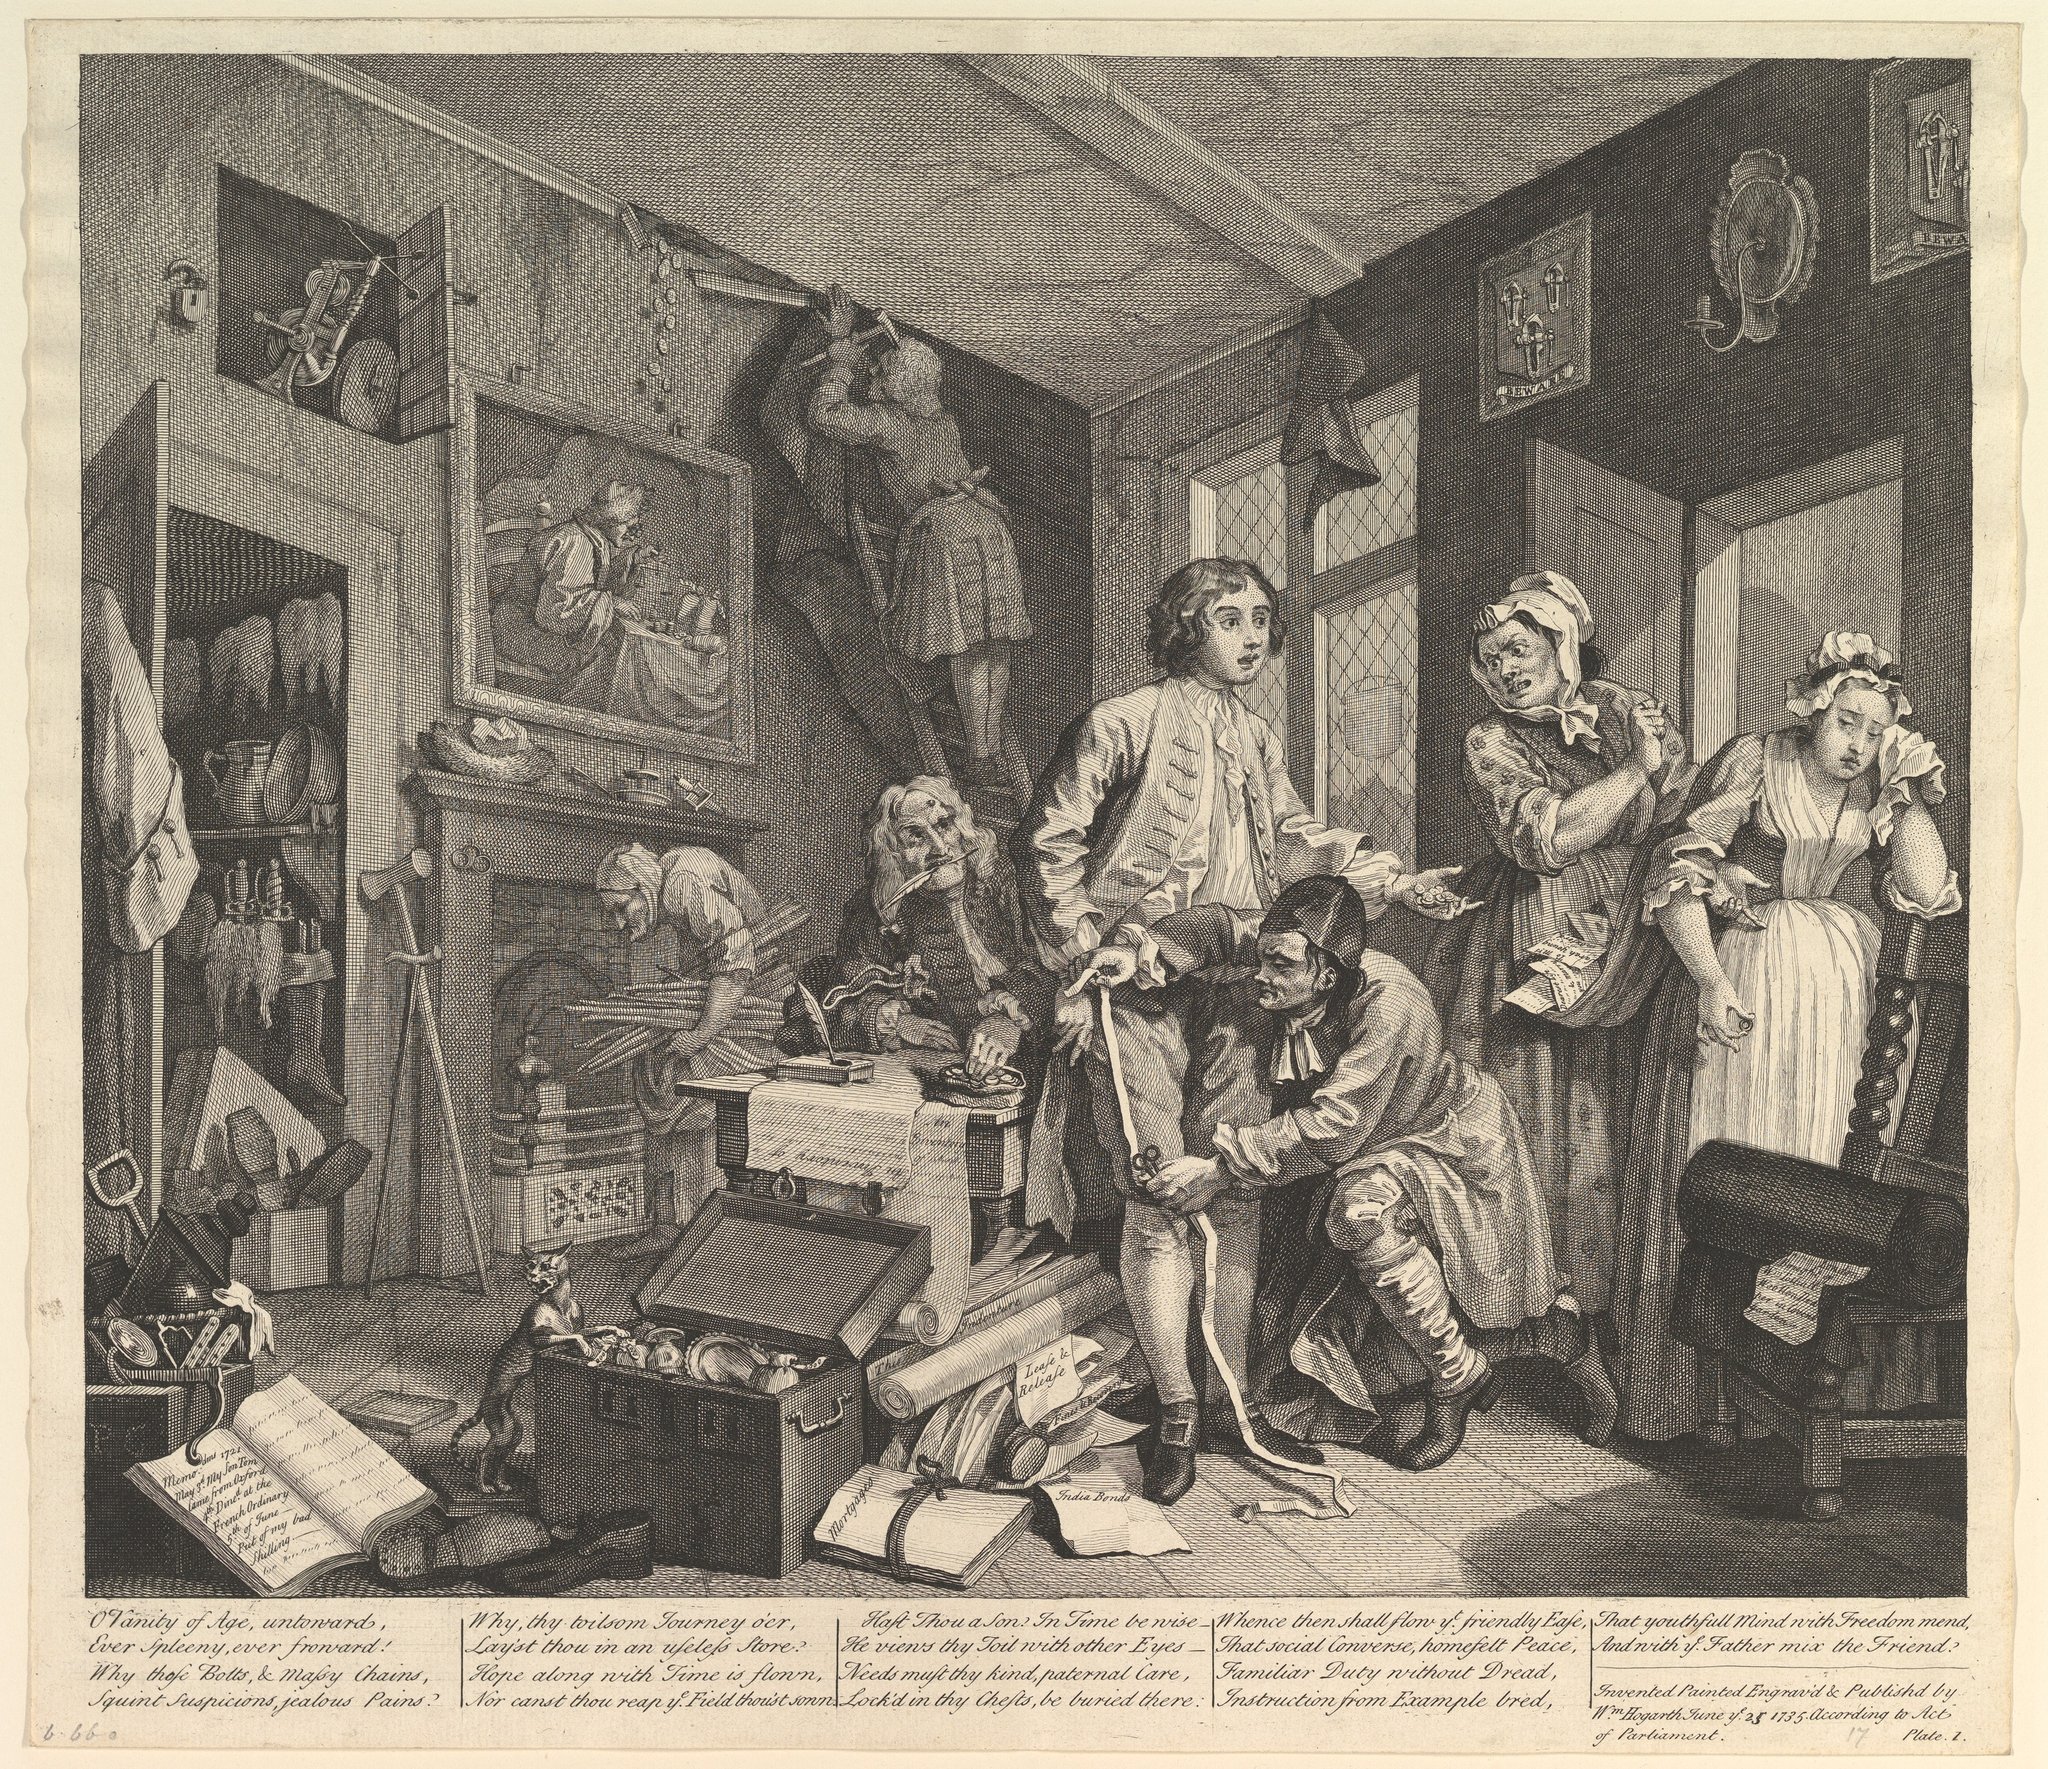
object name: print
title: A Rake's Progress, Plate 1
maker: william hogarth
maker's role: artist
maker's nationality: british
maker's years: 1697-1764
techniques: engraving, etching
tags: men,women,working